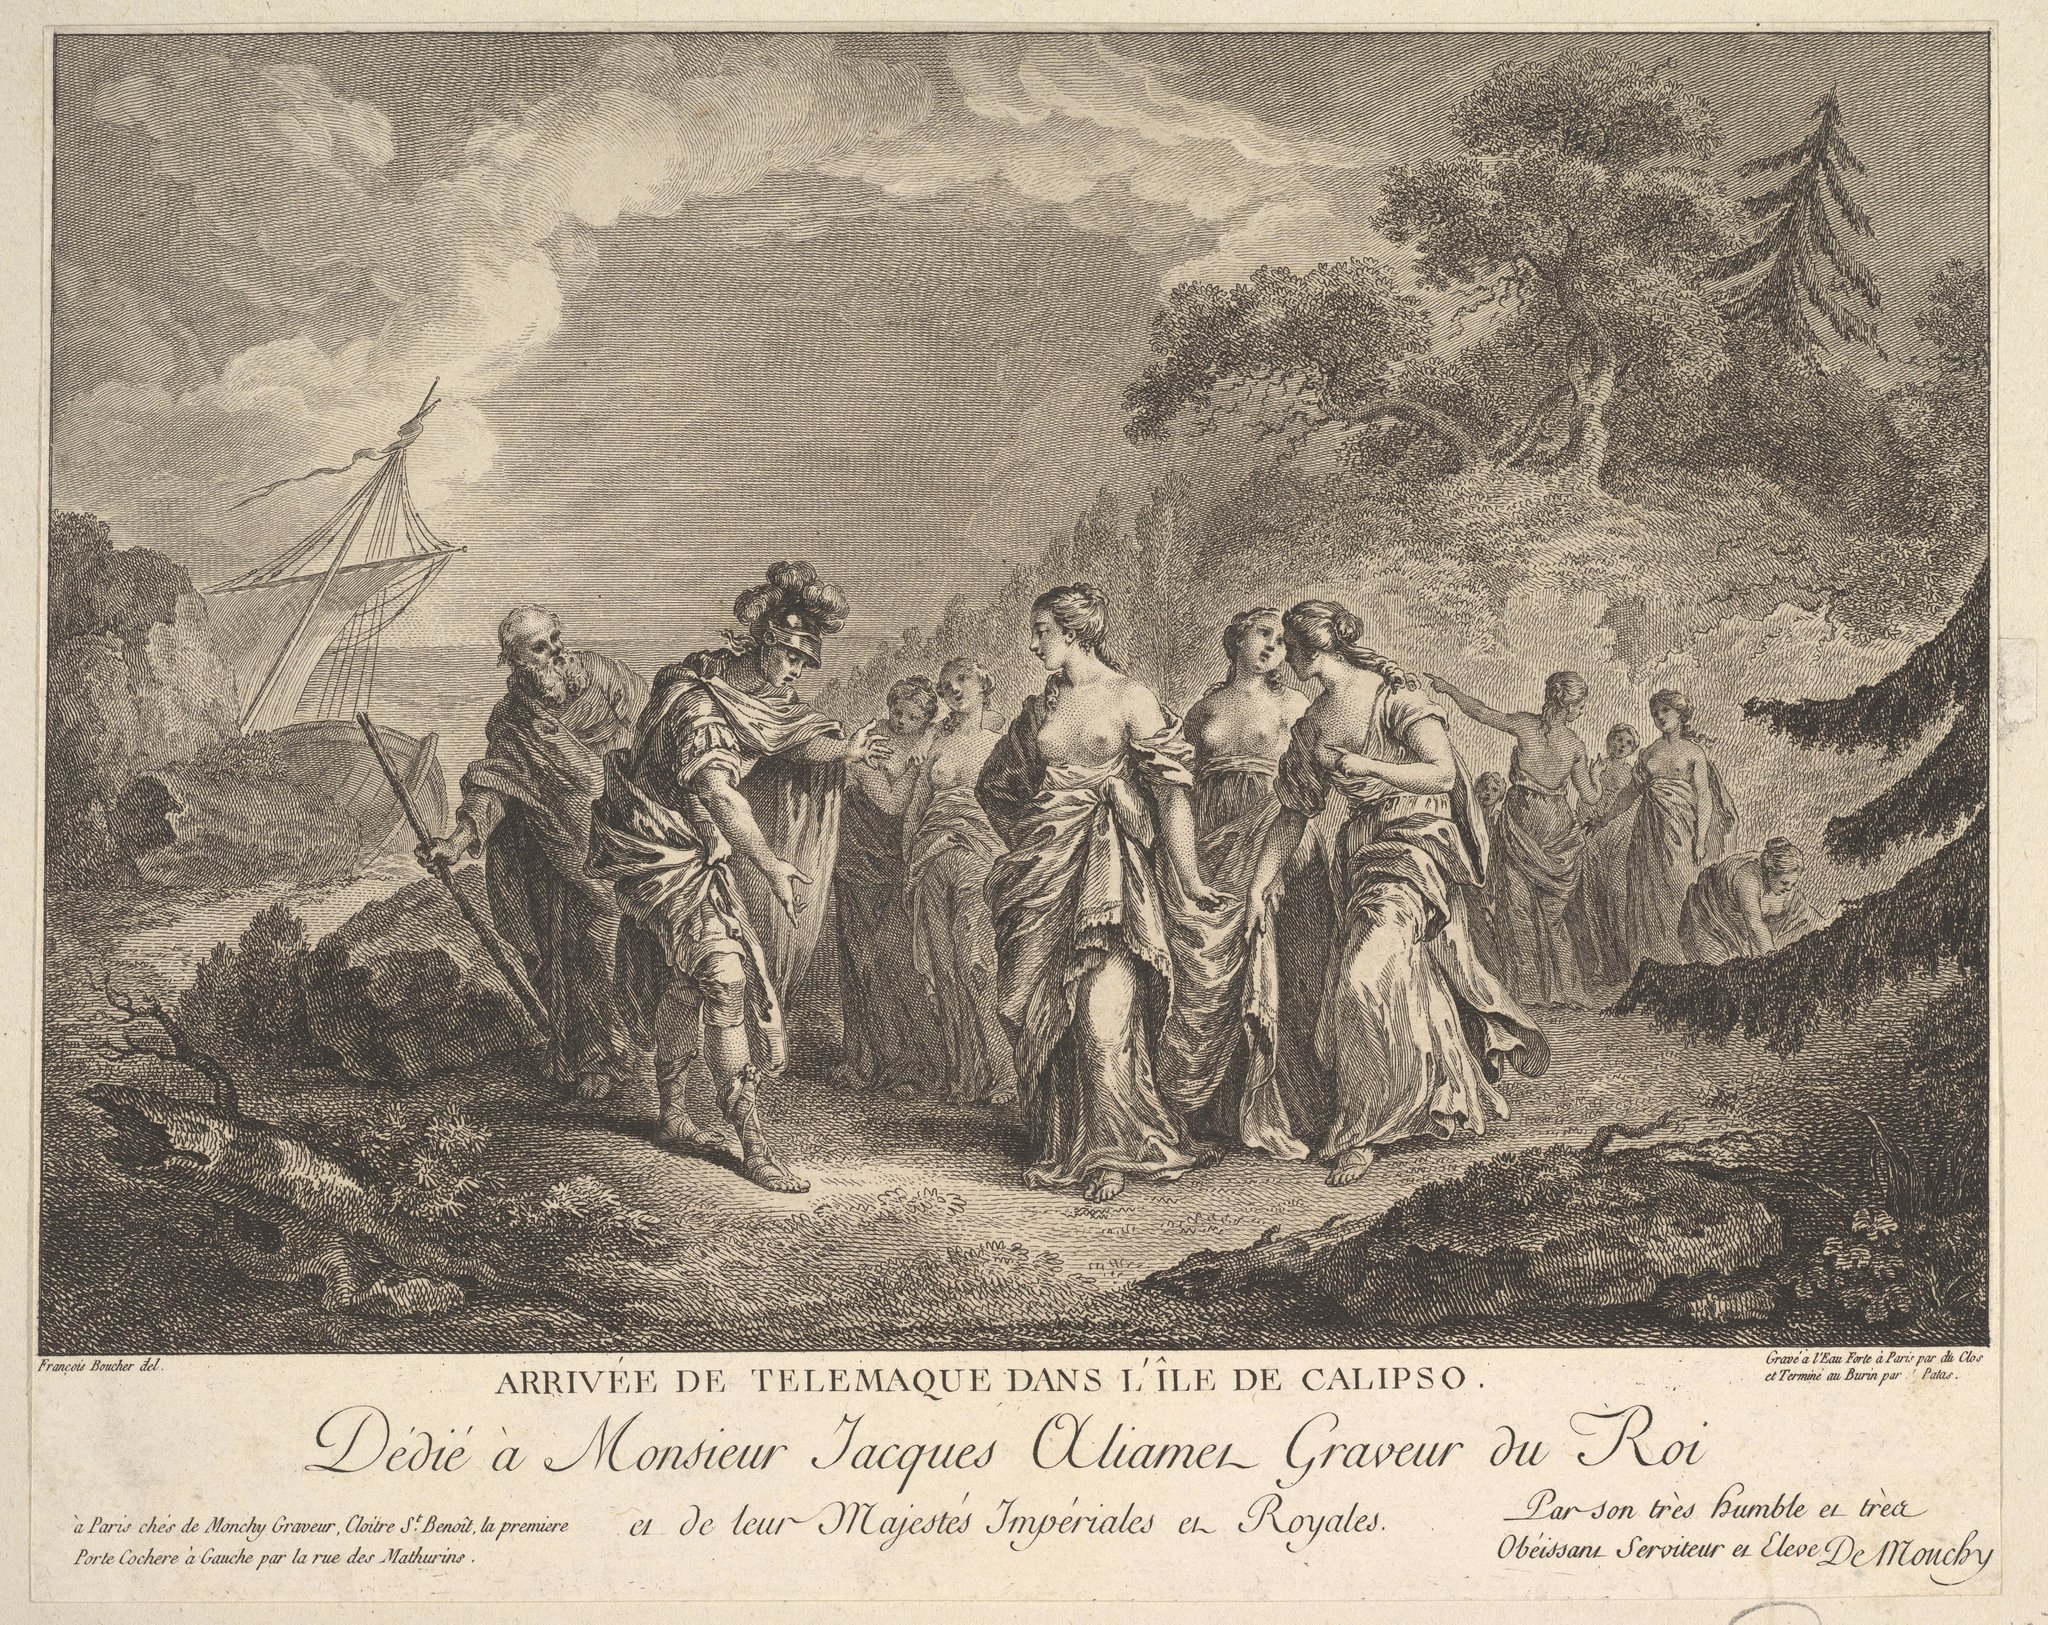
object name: print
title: Arrival of Telemachus at the Island of Calypso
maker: antoine jean duclos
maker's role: artist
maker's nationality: french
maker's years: 1742-1795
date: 1744-1795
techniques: engraving, etching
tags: men,female nudes,boats